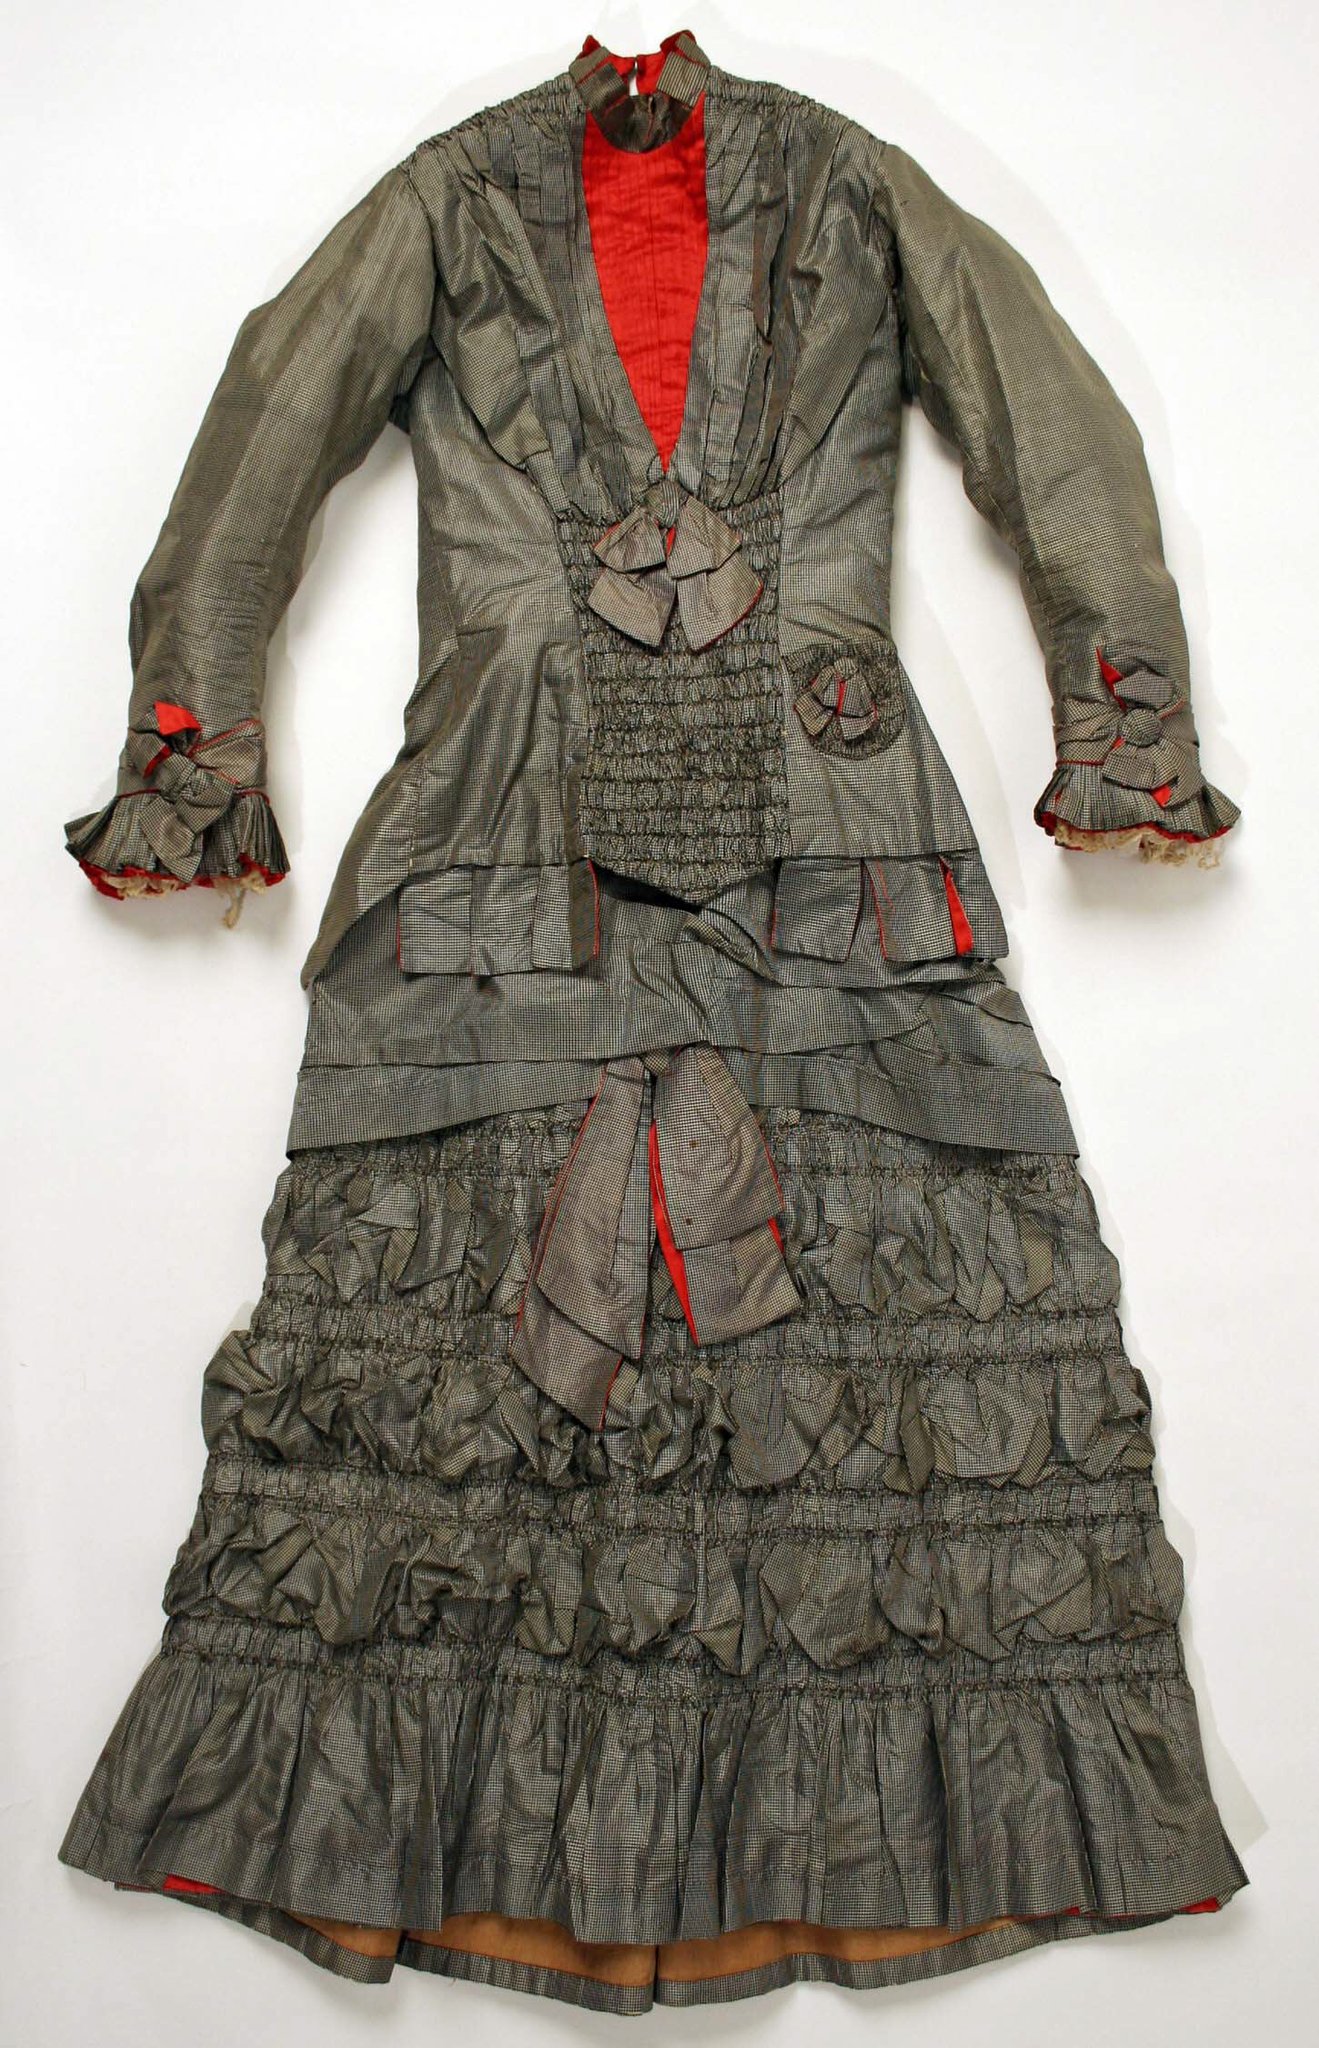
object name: dress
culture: american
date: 1882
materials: cotton, silk